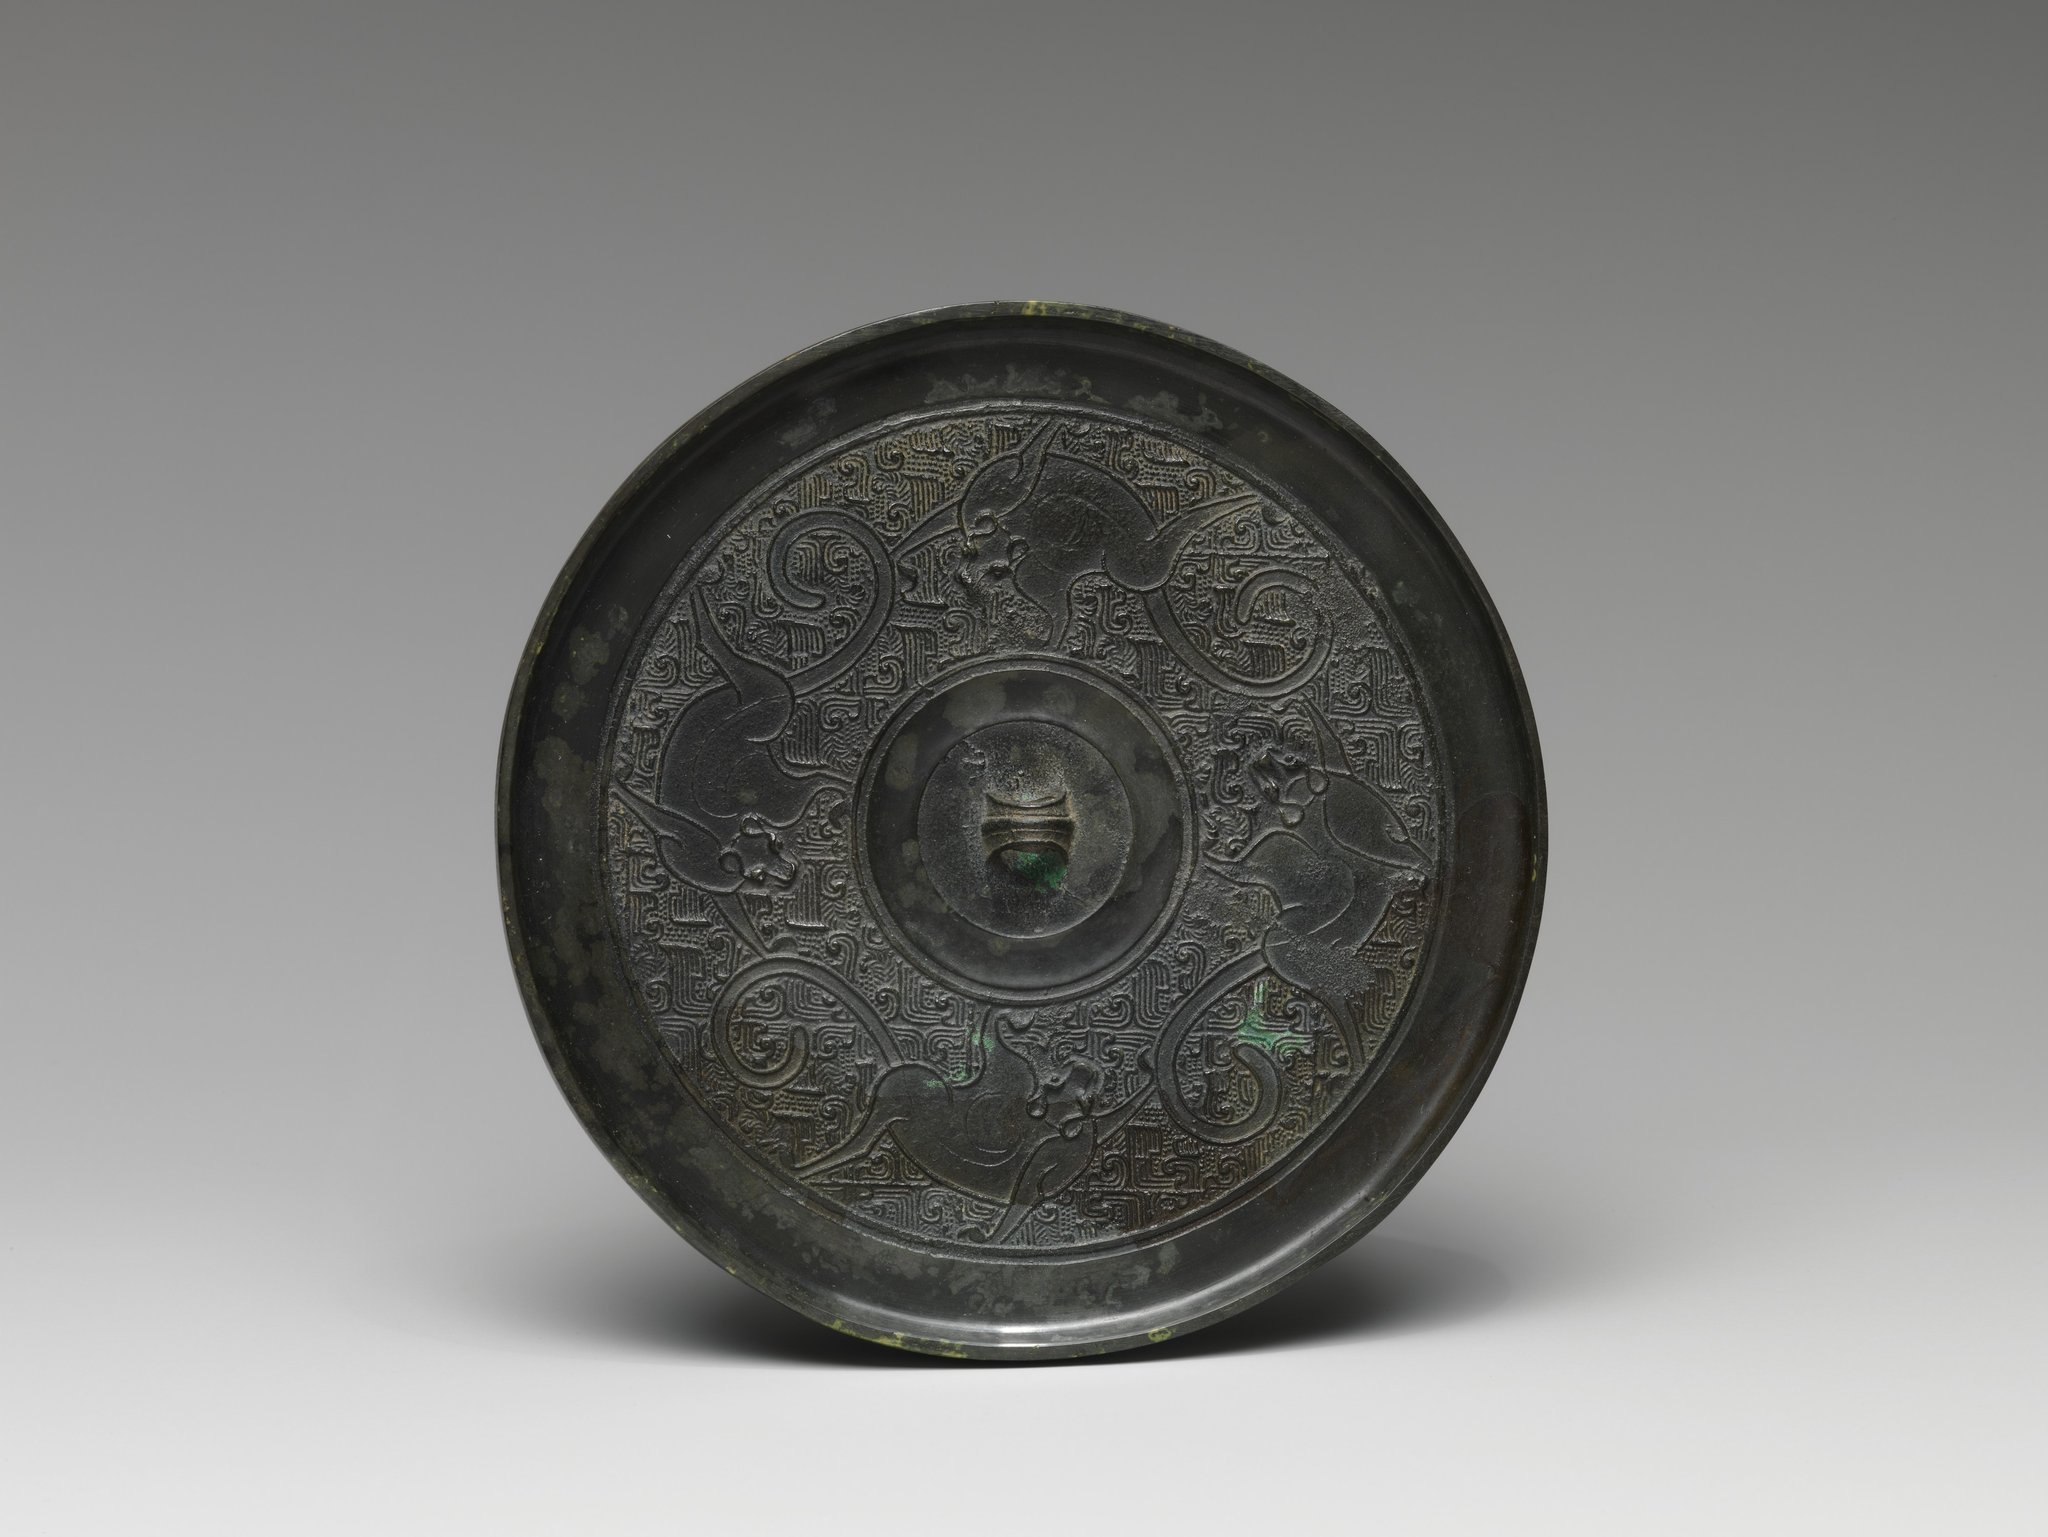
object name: mirror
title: Mirror with four felines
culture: chinese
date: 400-201 BCE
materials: bronze